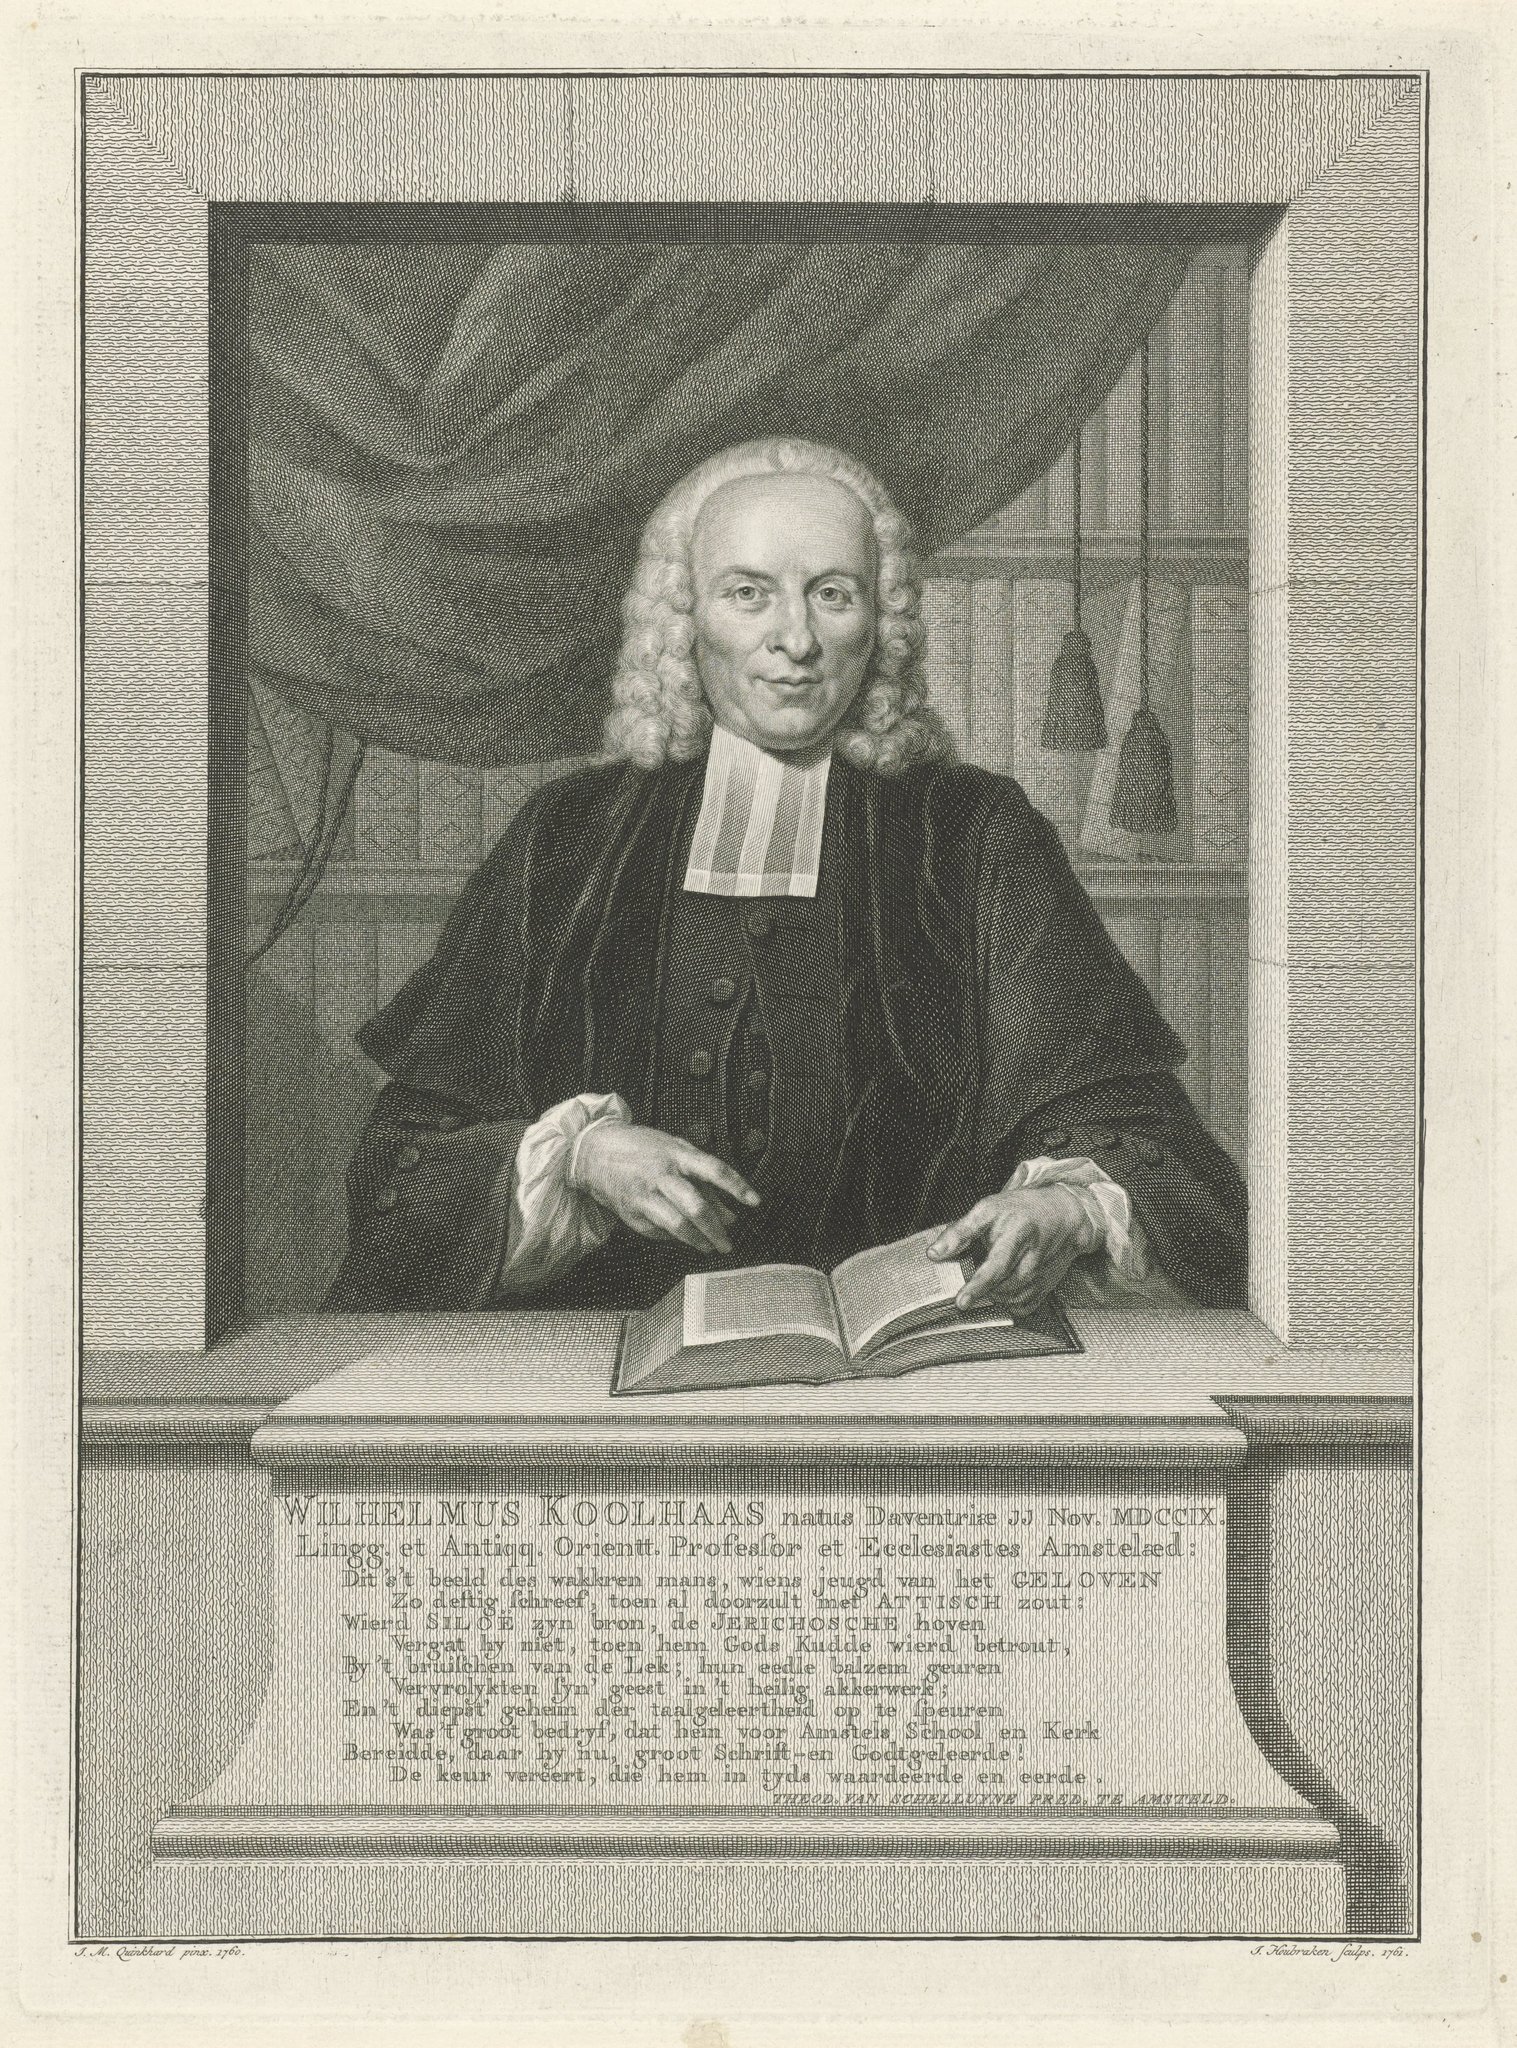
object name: print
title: Wilhelmus Koolhaas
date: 1761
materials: paper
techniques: engraving, etching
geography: amsterdam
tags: the bible as a book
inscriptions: collector's mark: Lugt 2228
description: Portret ten halven lijve van Willem Coolhaes op 51-jarige leeftijd in een venster met voor hem op de vensterbank een bijbel. Achter hem een gordijn een een boekenkast. Onder het portret zijn naam en gegevens in twee regels in het Latijn en daaronder een tienregelig vers in het Nederlands.